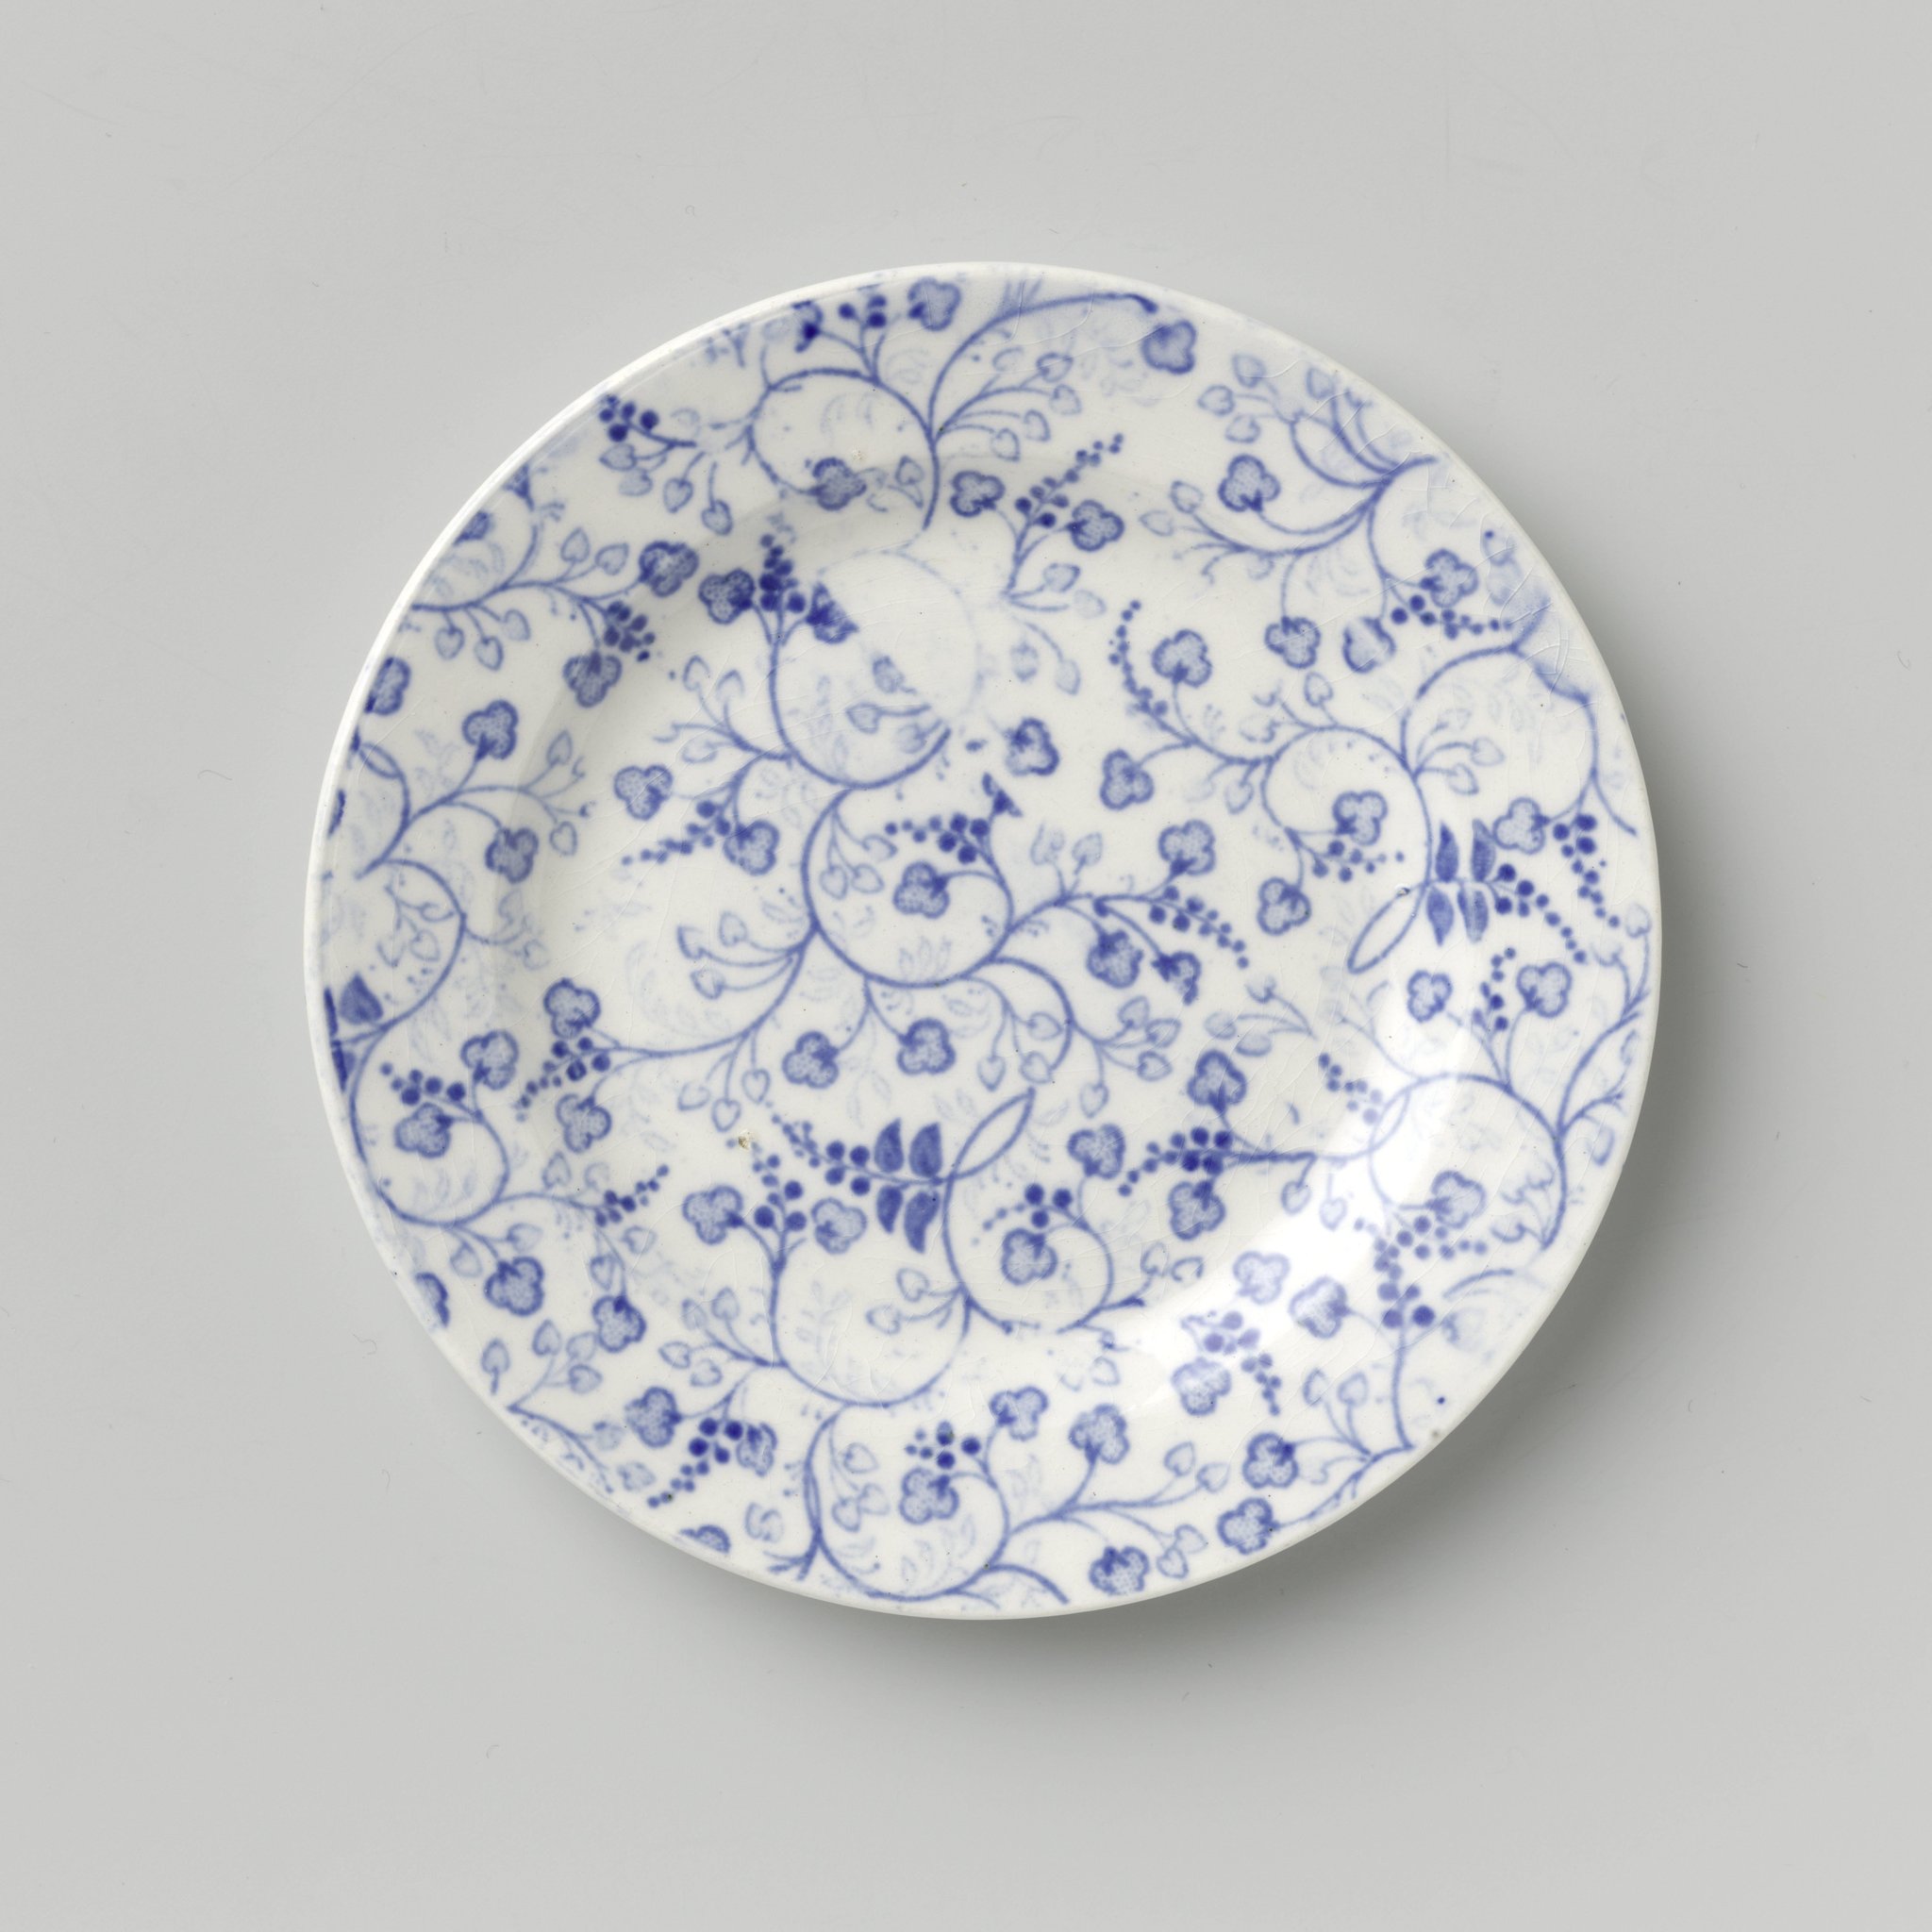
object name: plate dish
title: Bord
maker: petrus regout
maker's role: plateelbakker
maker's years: 1801-1879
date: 1867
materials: creamware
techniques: transfer decoration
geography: maastricht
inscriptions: mark: ‘PETRUS REGOUT // MAASTRICHT 5’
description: Bord van aardewerk, met blauw doorlopend bloemendecor, behorend tot een kinderservies.